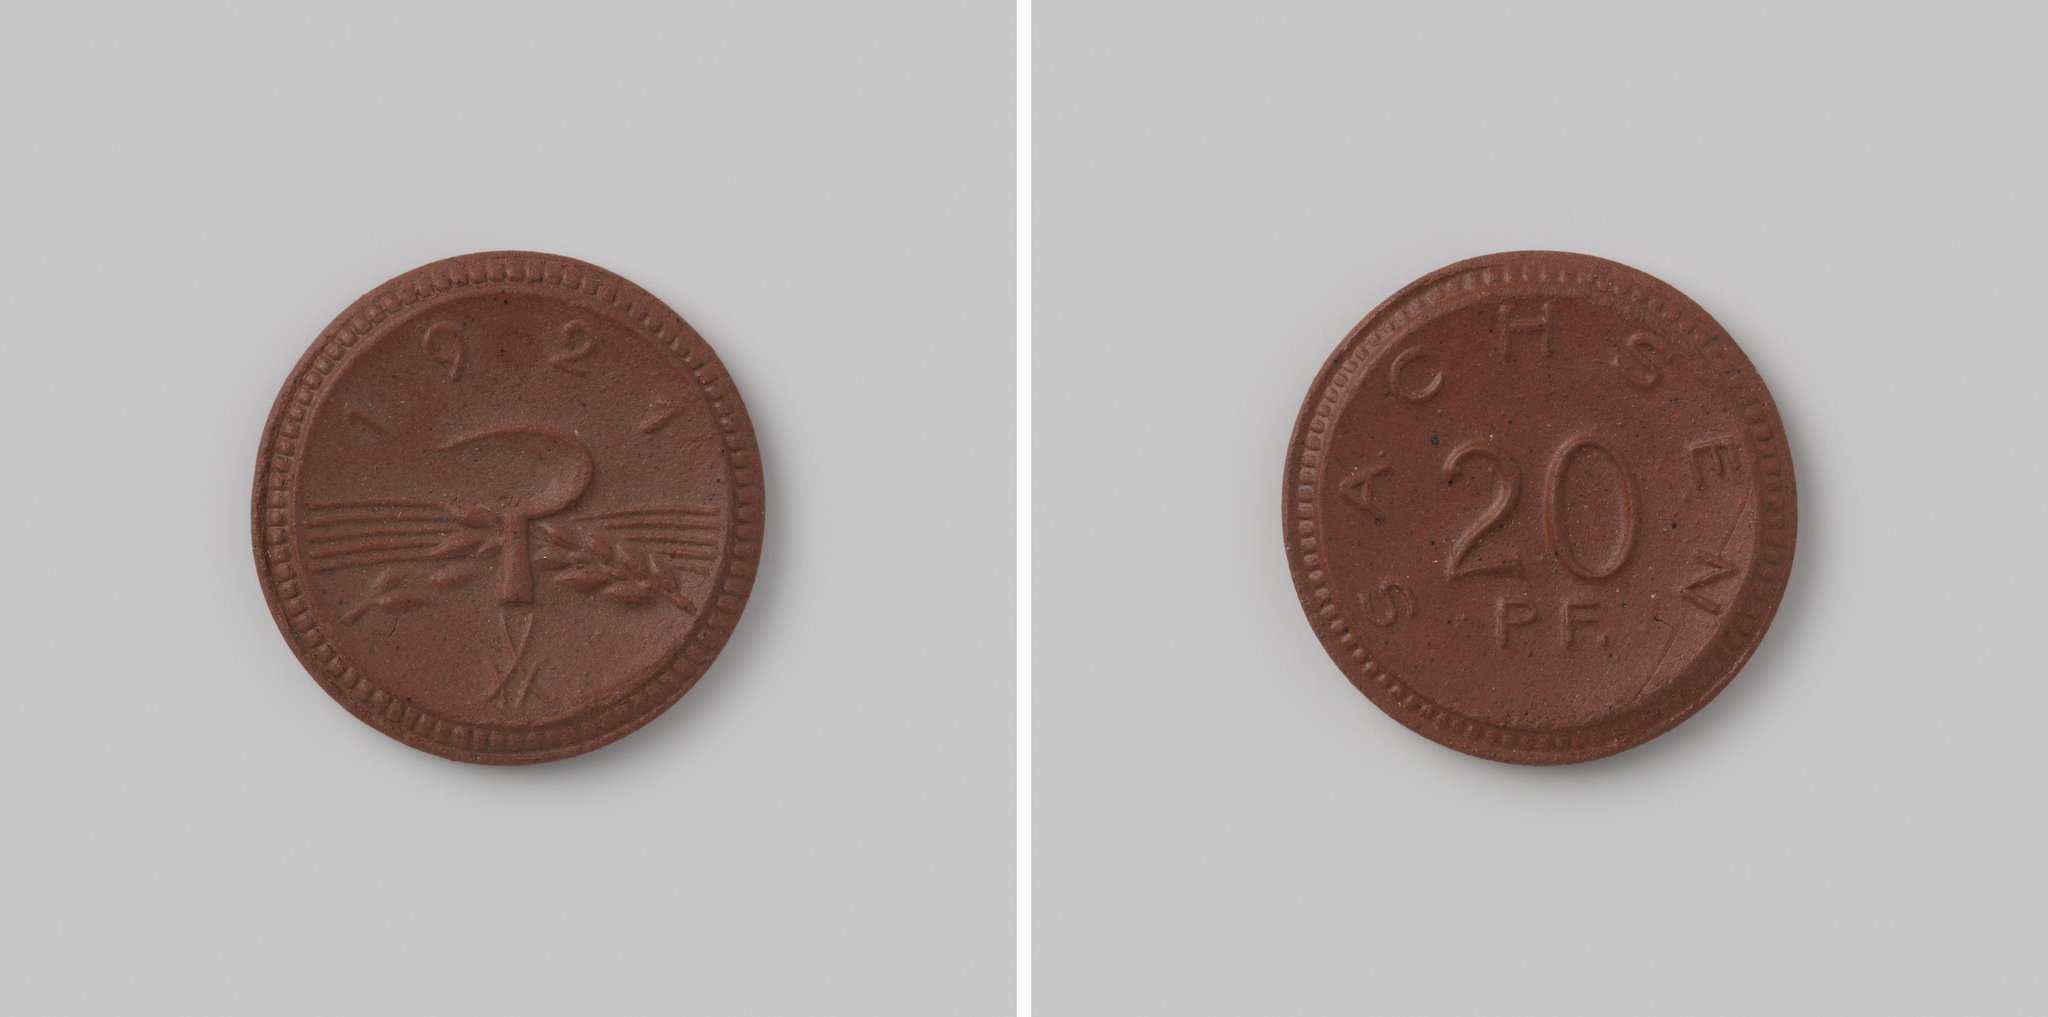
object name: coin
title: 20 pfennig uit Duitsland, Saksen, 1921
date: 1921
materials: porcelain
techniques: casting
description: Porseleinen pseudomunt. Voorzijde: sikkel op twee korenaren, waarboven jaartal. Keerzijde: waarde-aanduiding in twee regels. Daaromheen land-aanduiding. Gladde rand.